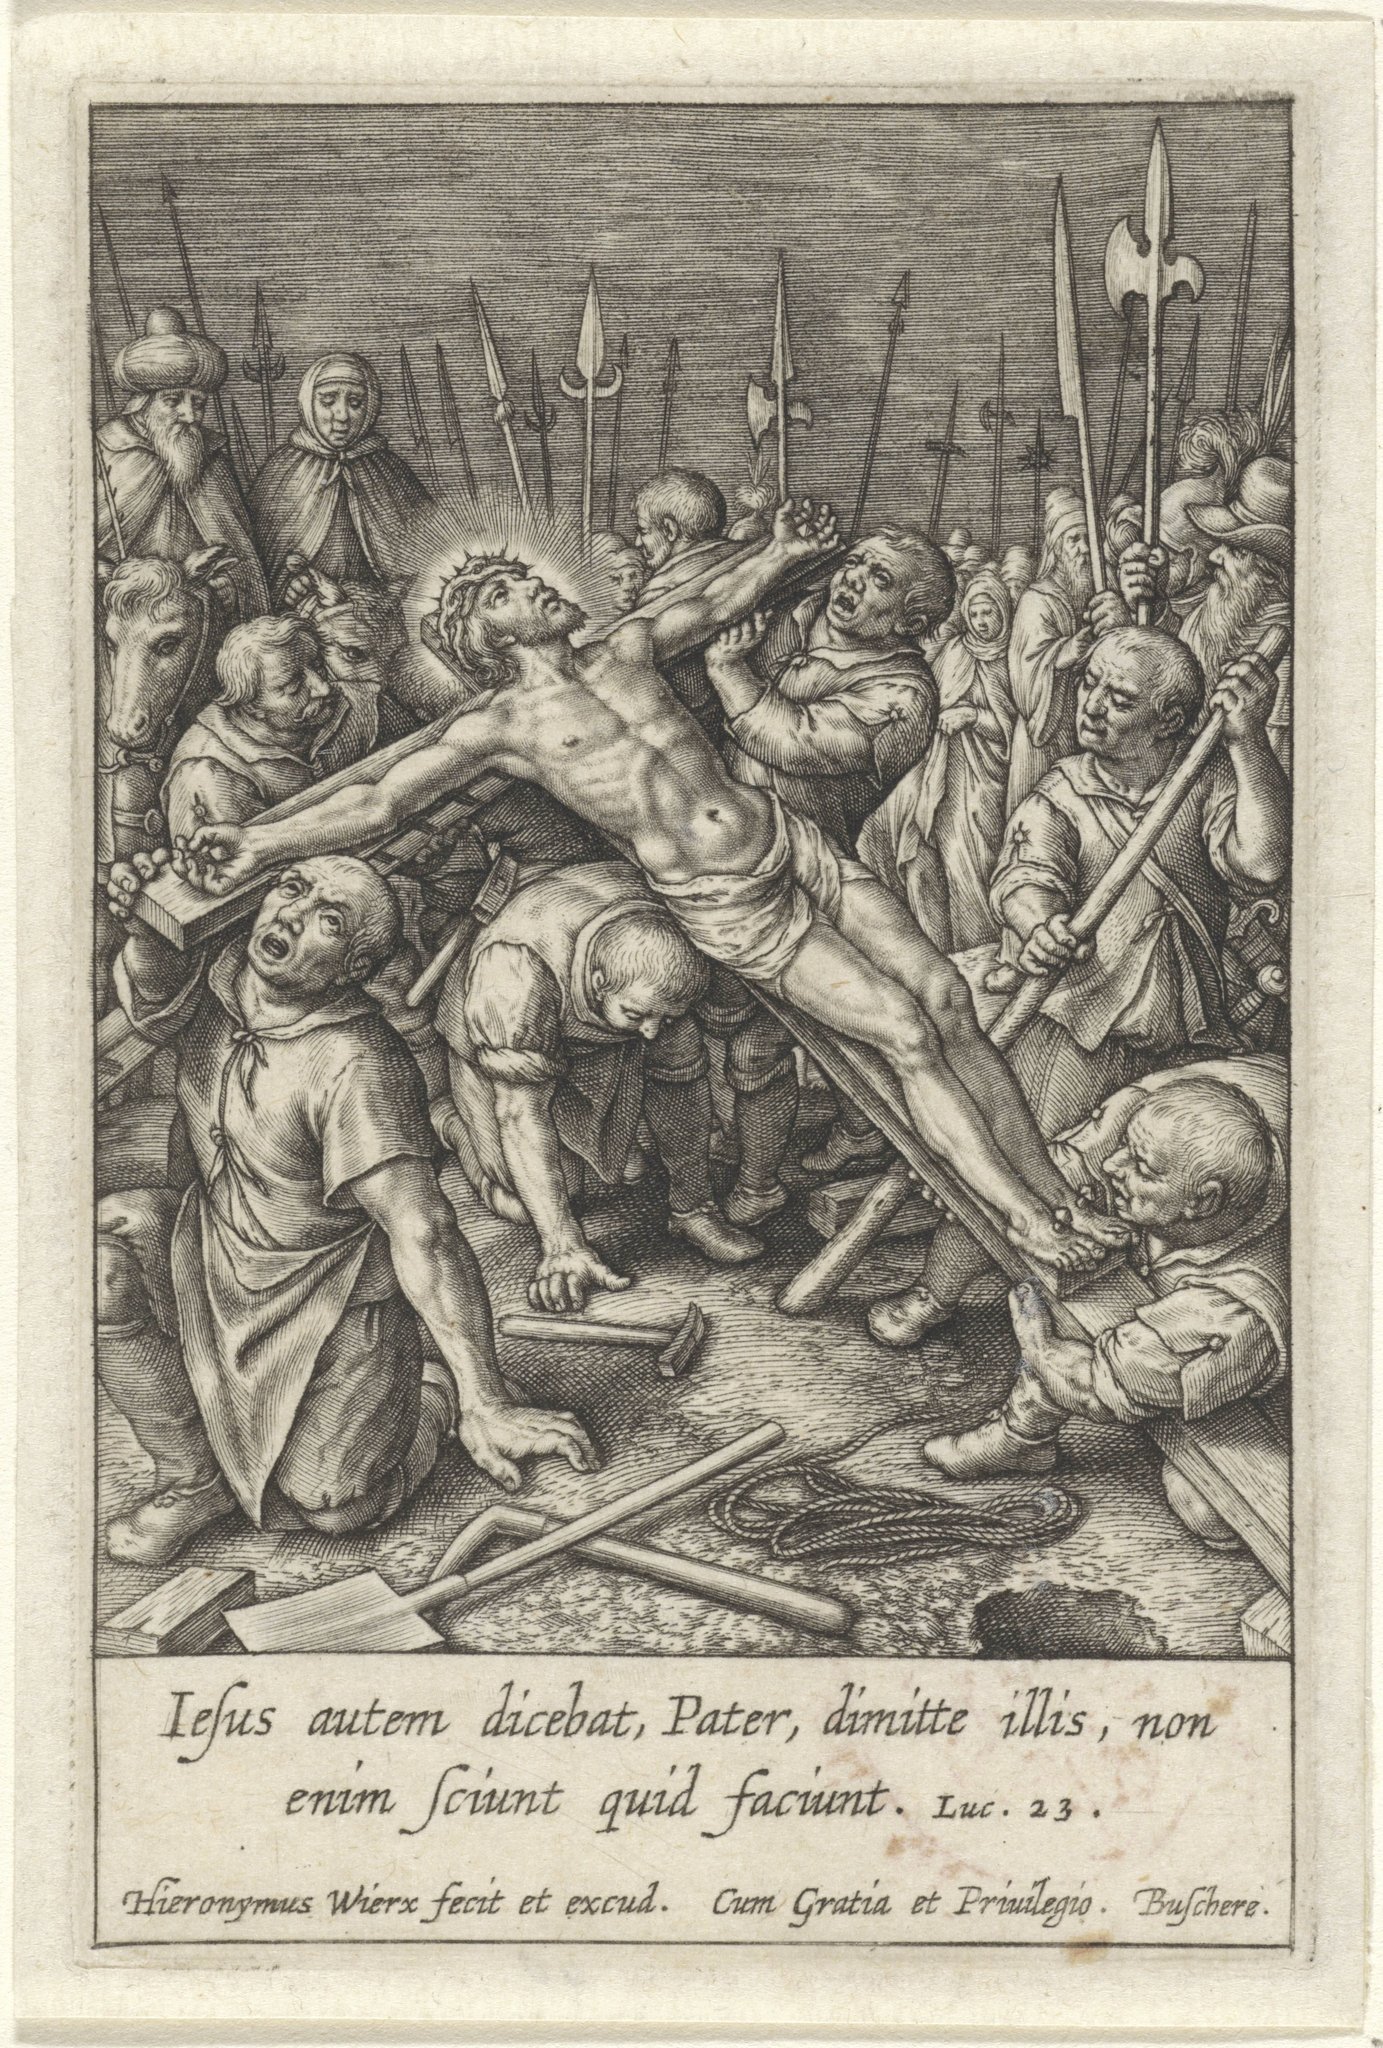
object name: print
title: Passie van Christus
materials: paper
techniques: engraving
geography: antwerp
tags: raising of the cross to which christ is nailed already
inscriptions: collector's mark: Lugt 240, number: ‘60’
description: Christus is aan het kruis genageld dat door vier mannen wordt opgetild. Op de achtergrond kijkt Pilatus te paard toe. In de marge een tweeregelig Bijbelcitaat uit Luc. 23 in het Latijn.